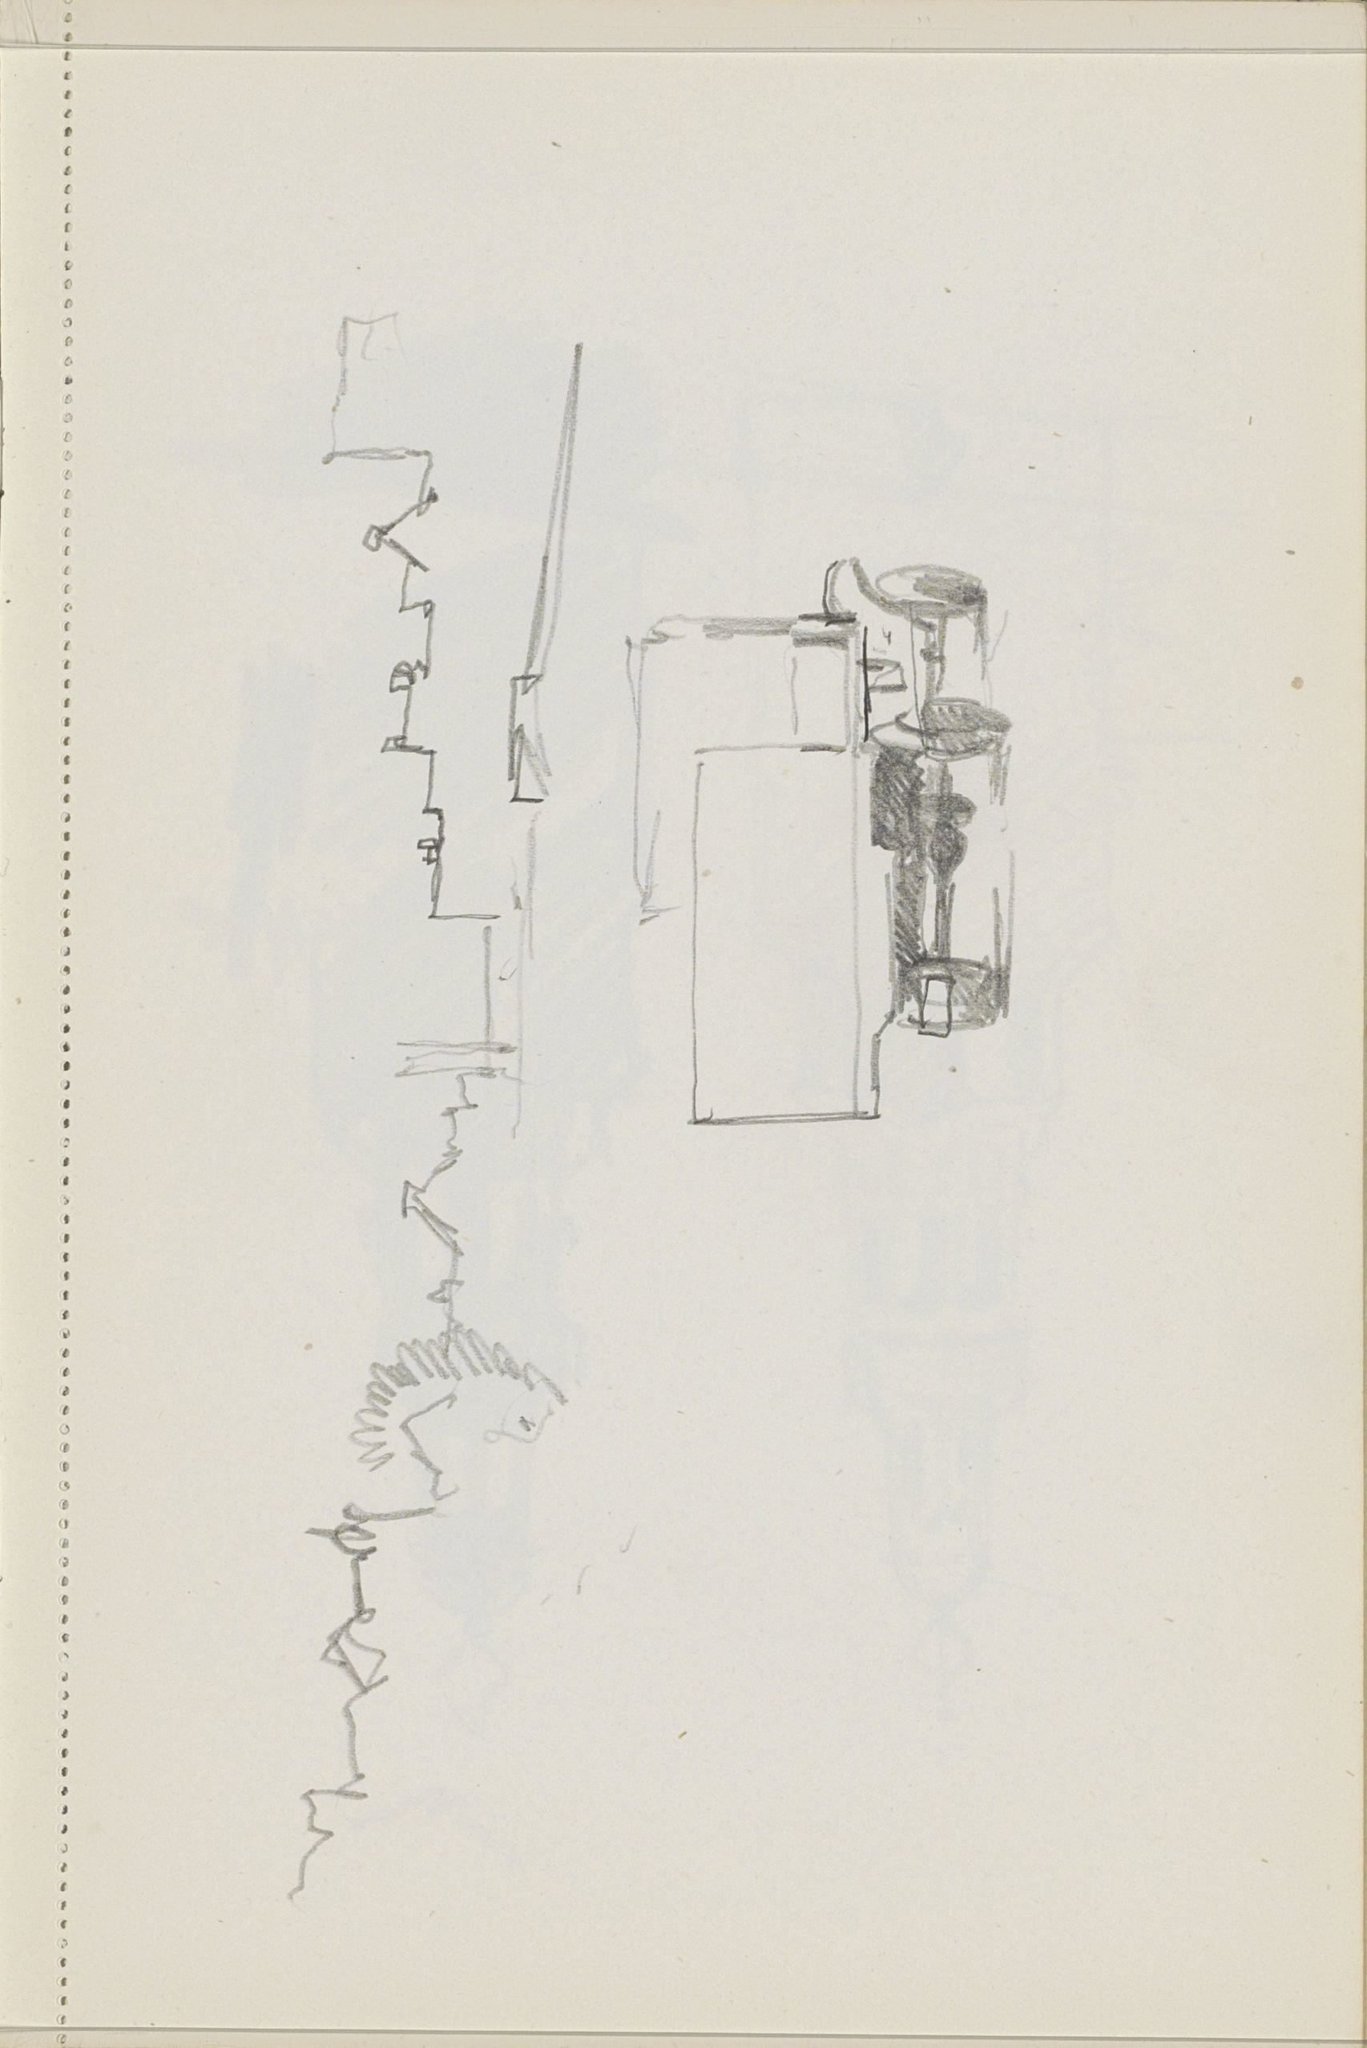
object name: sketchbook leaf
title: Silhouet van een stad en een vrachtwagen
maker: cornelis vreedenburgh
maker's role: draughtsman, print maker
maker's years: 1880-1946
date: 1890-1946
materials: paper, pencil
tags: city-view, and landscape with man-made constructions, traffic by road or path with motor-vehicle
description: Blad 61 recto uit een schetsboek met uit 75 bladen.